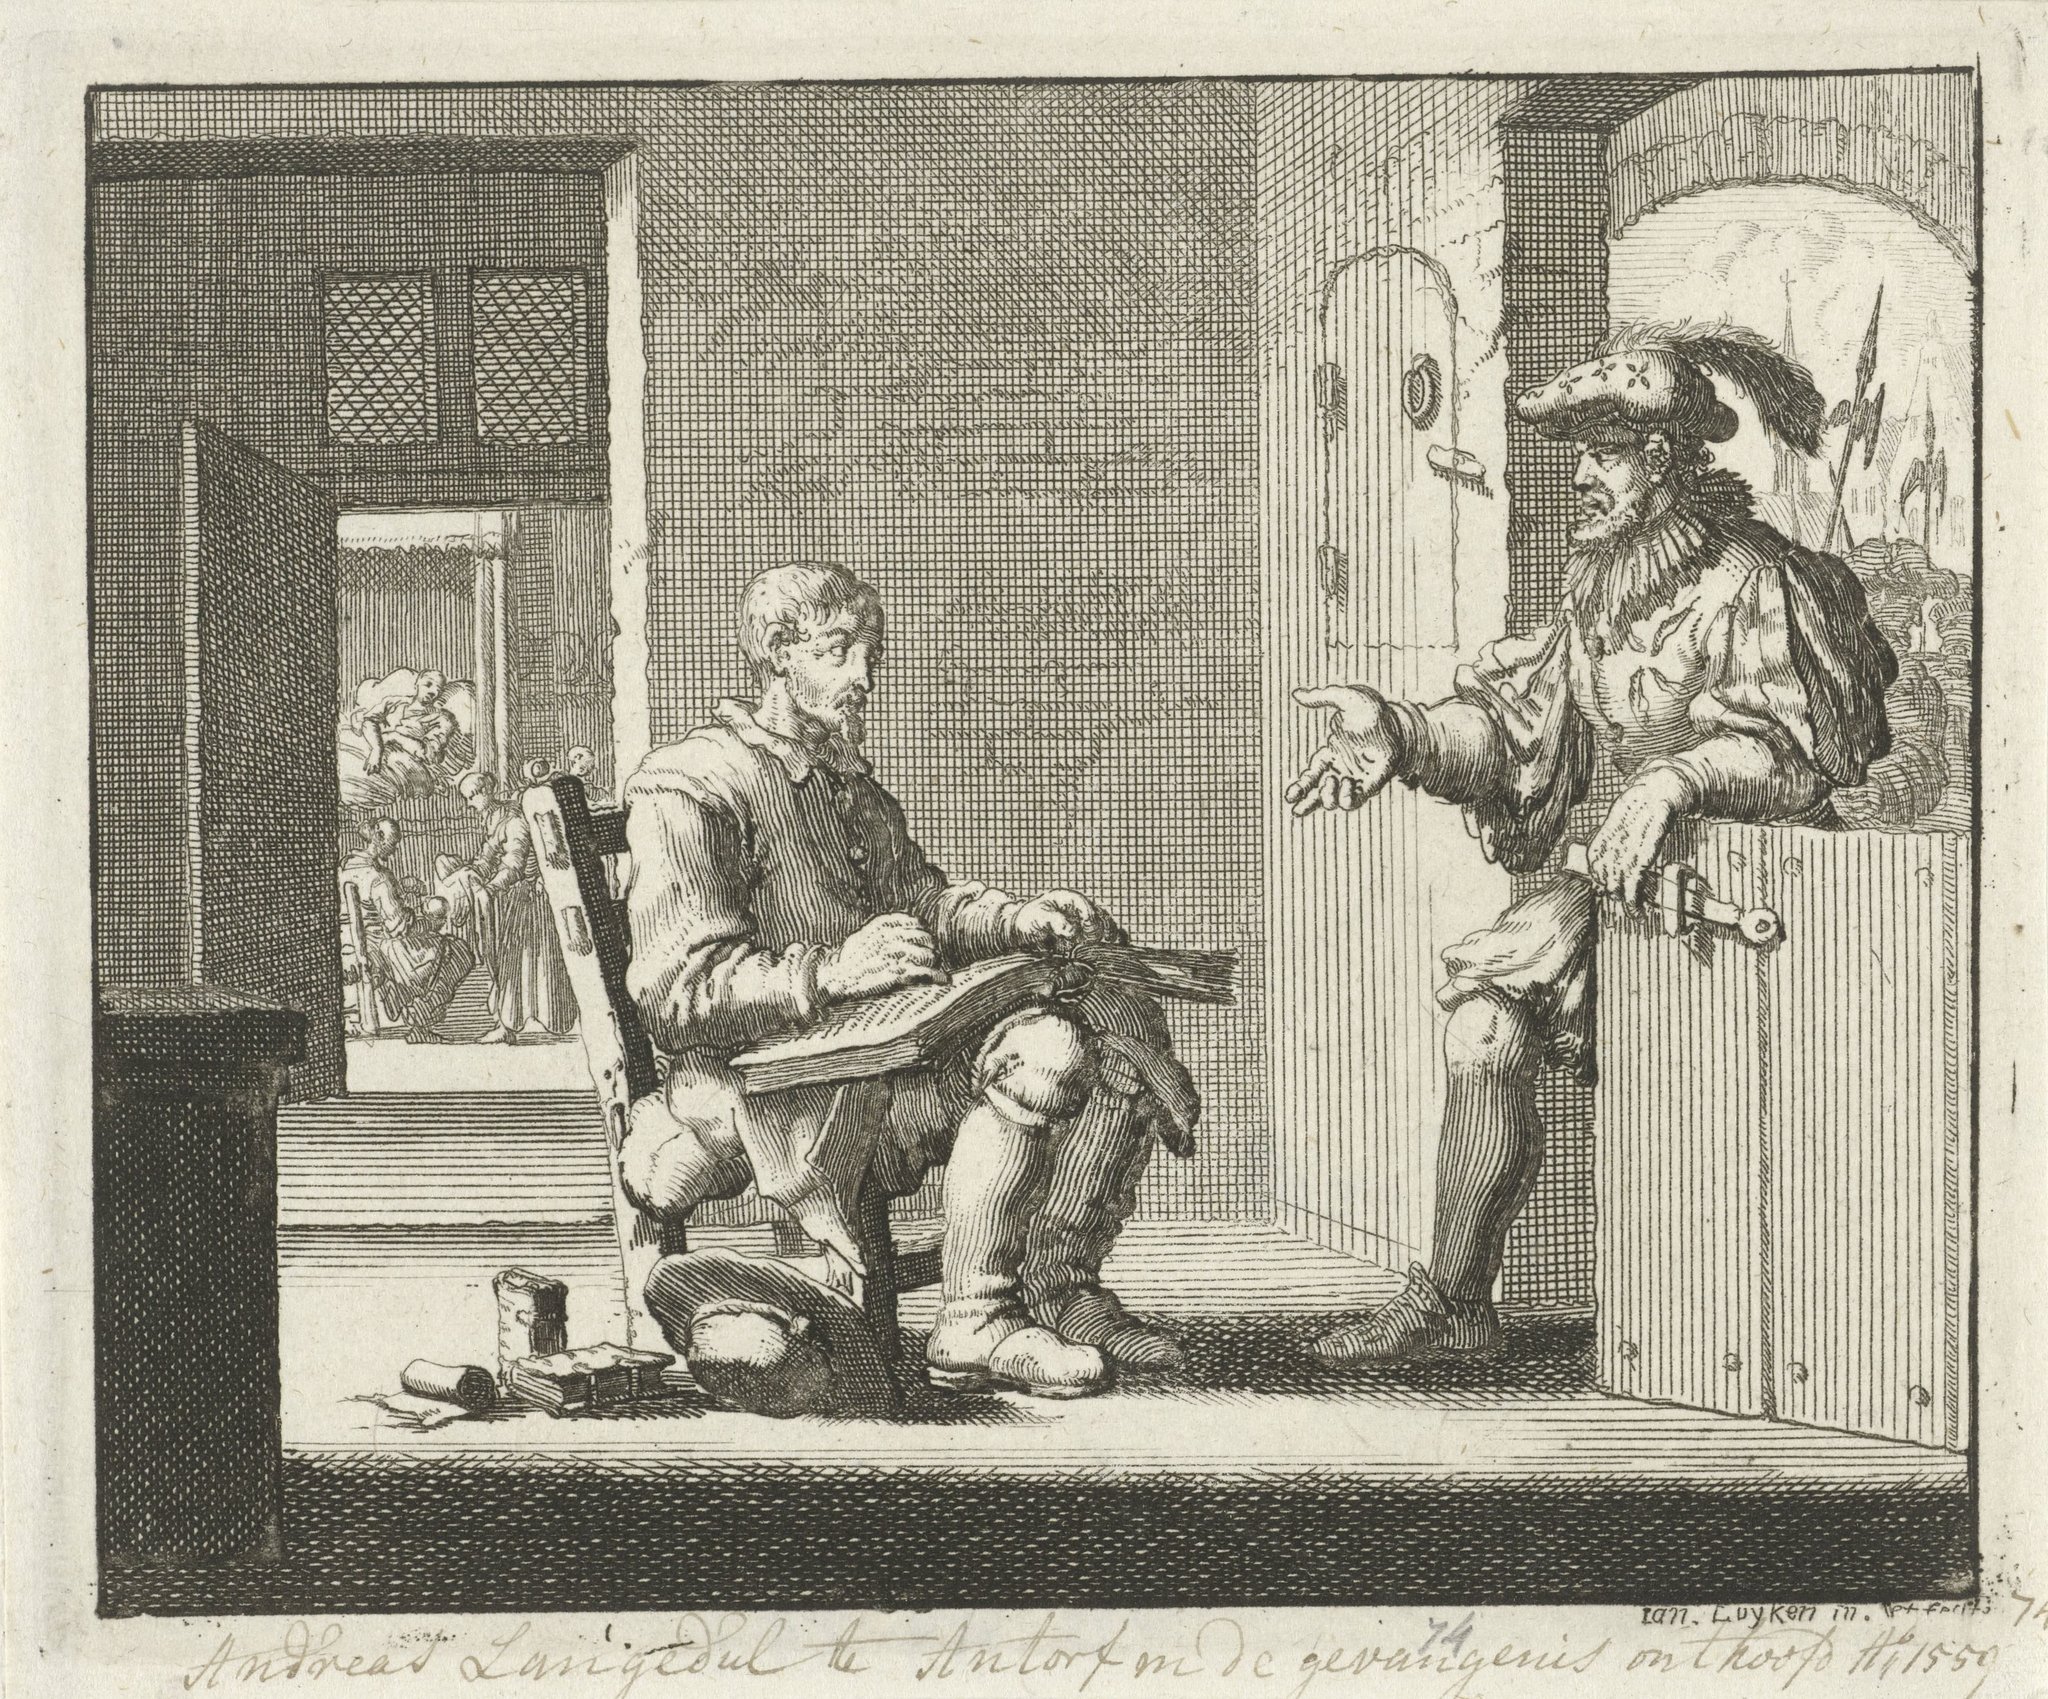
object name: print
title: Andries Langedul te Antwerpen gevangengenomen onder het lezen van de Bijbel, 1559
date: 1685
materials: paper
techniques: etching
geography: amsterdam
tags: reading the bible or other religious books, persecution of heretics, antwerp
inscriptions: number: ‘74’, collector's mark: Lugt 2228, inscription: ‘Andreas Langedul [...] Ao 1559’